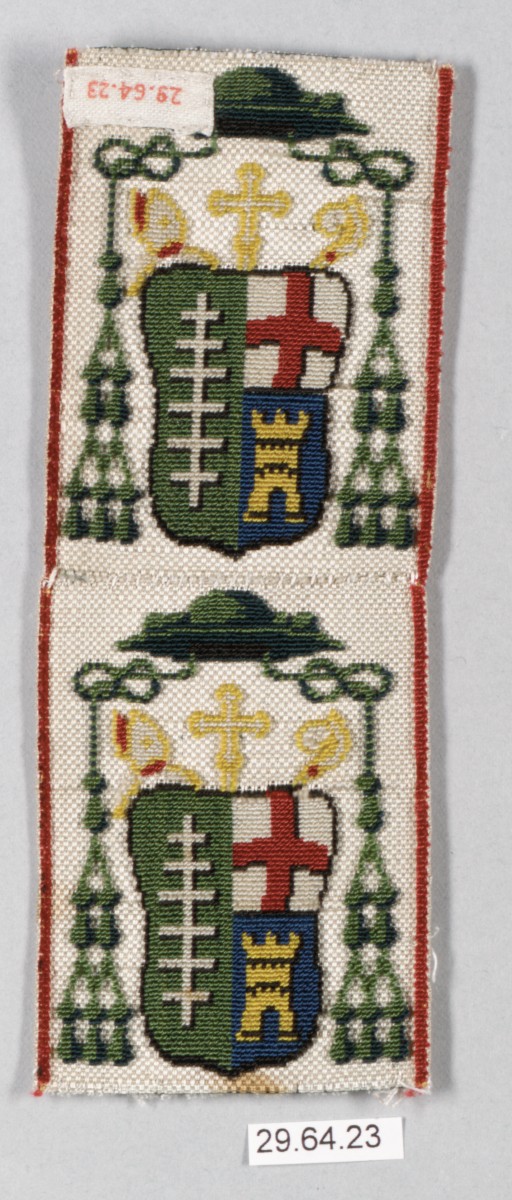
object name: galloon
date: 1701-1900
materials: silk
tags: cross,insignia